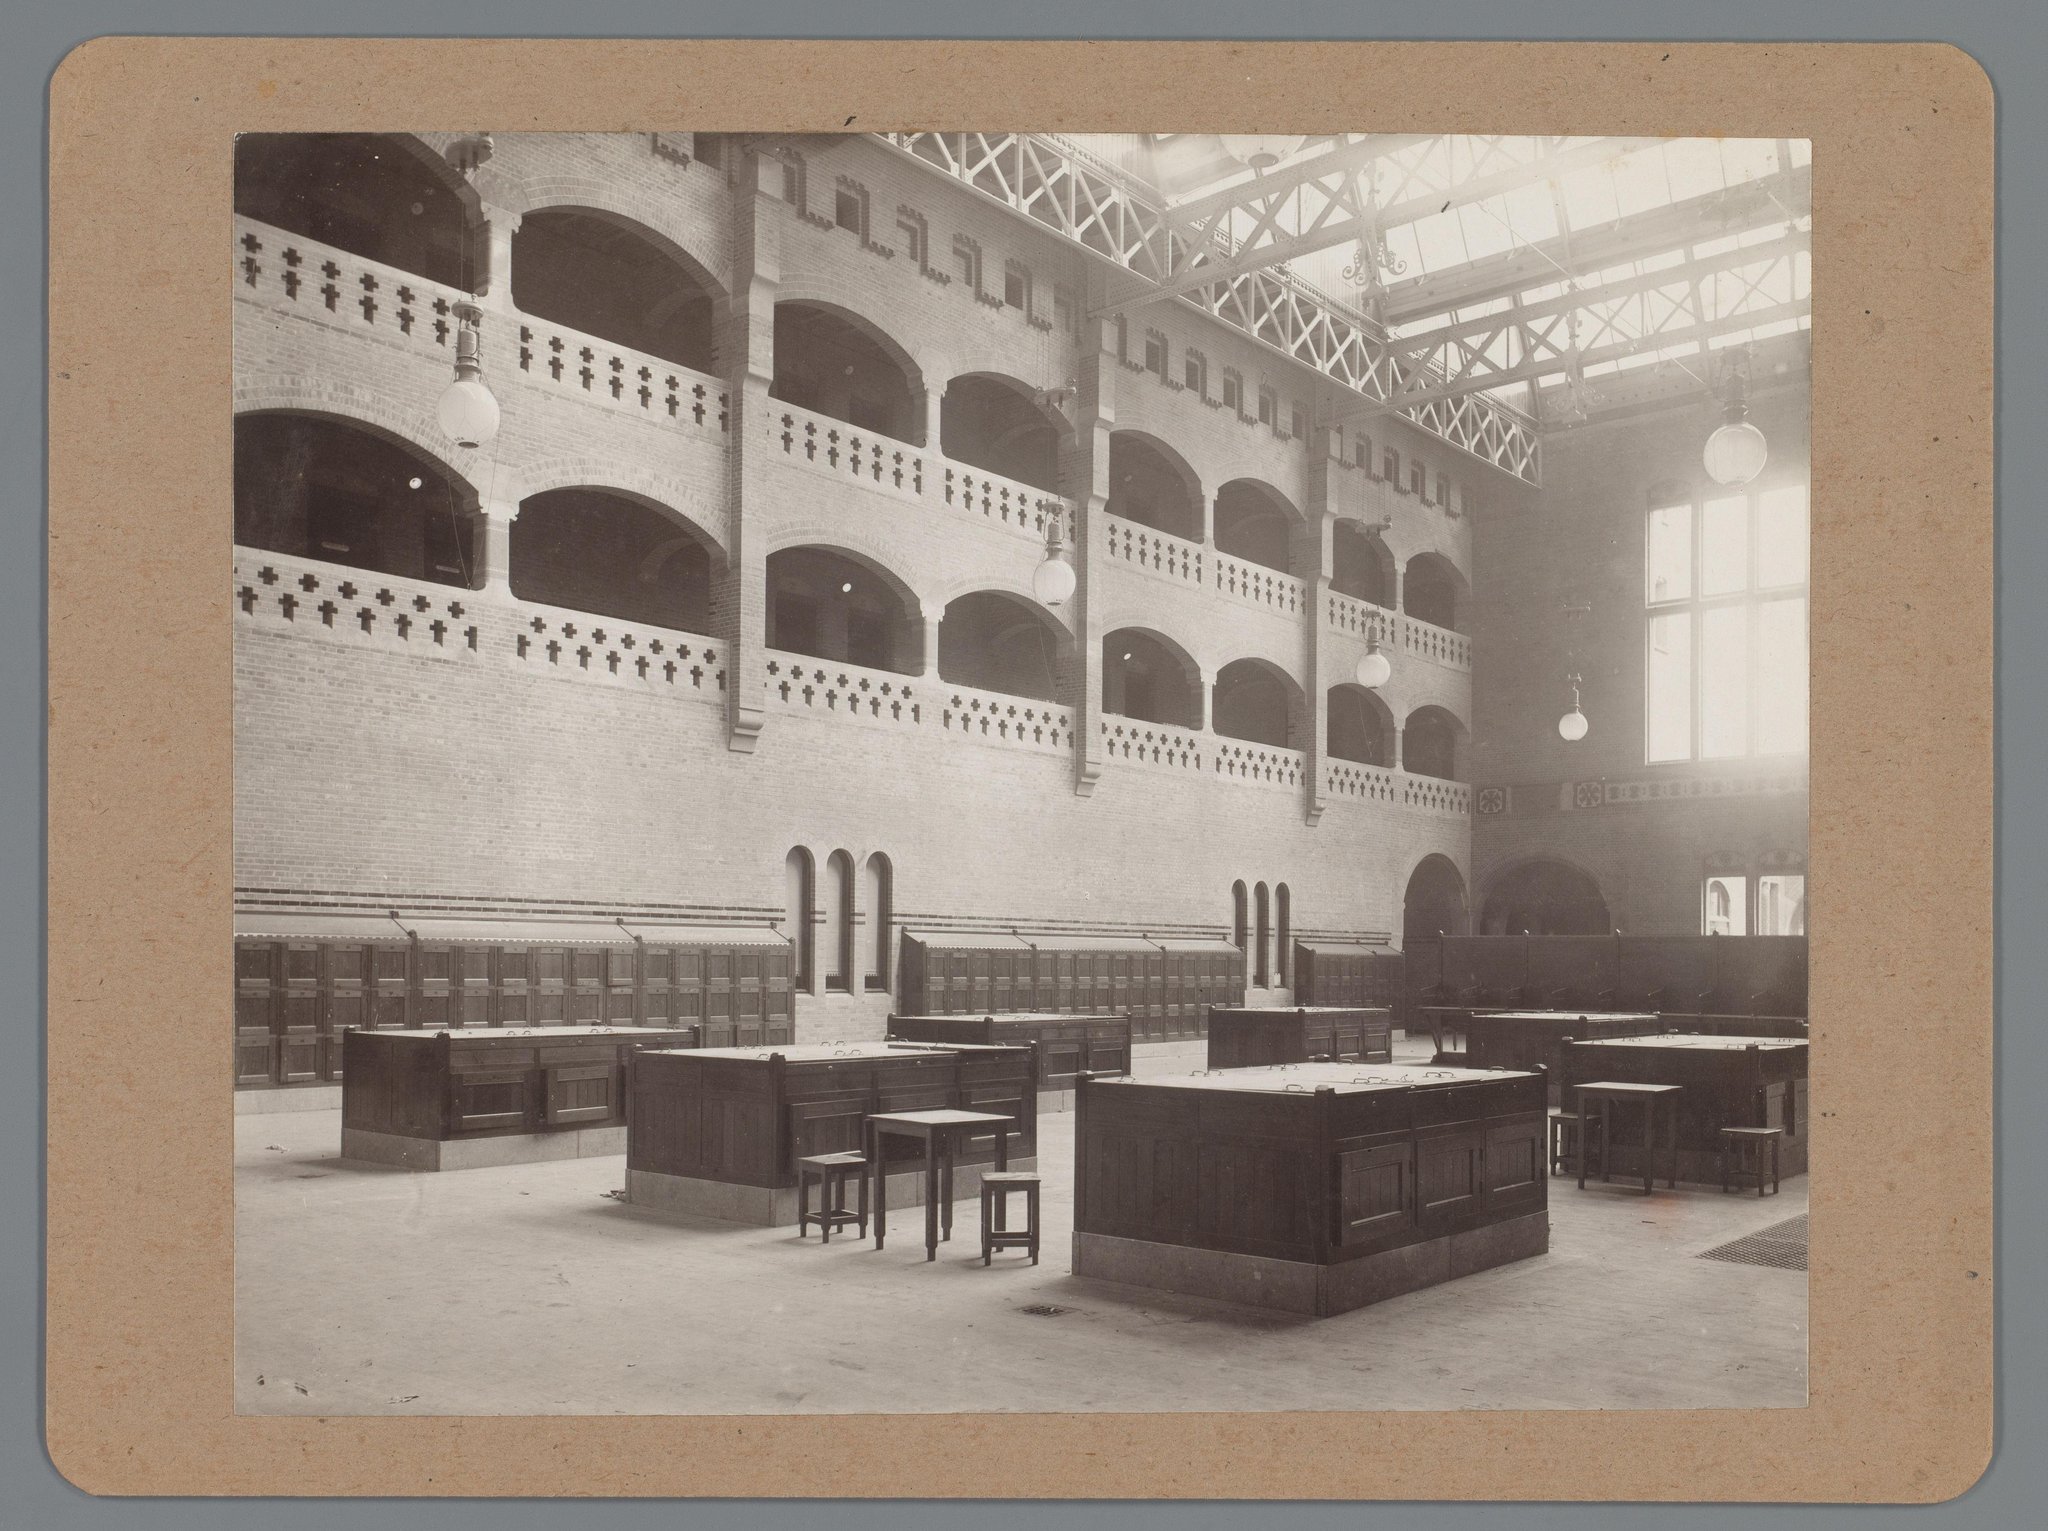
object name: photograph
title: Graanbeurszaal van de Beurs van Berlage te Amsterdam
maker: Anonymous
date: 1903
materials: paper, cardboard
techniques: gelatin silver print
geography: amsterdam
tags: stock exchange, stock-market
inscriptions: stamp: ‘Rijksmuseum/ Amsterdam’